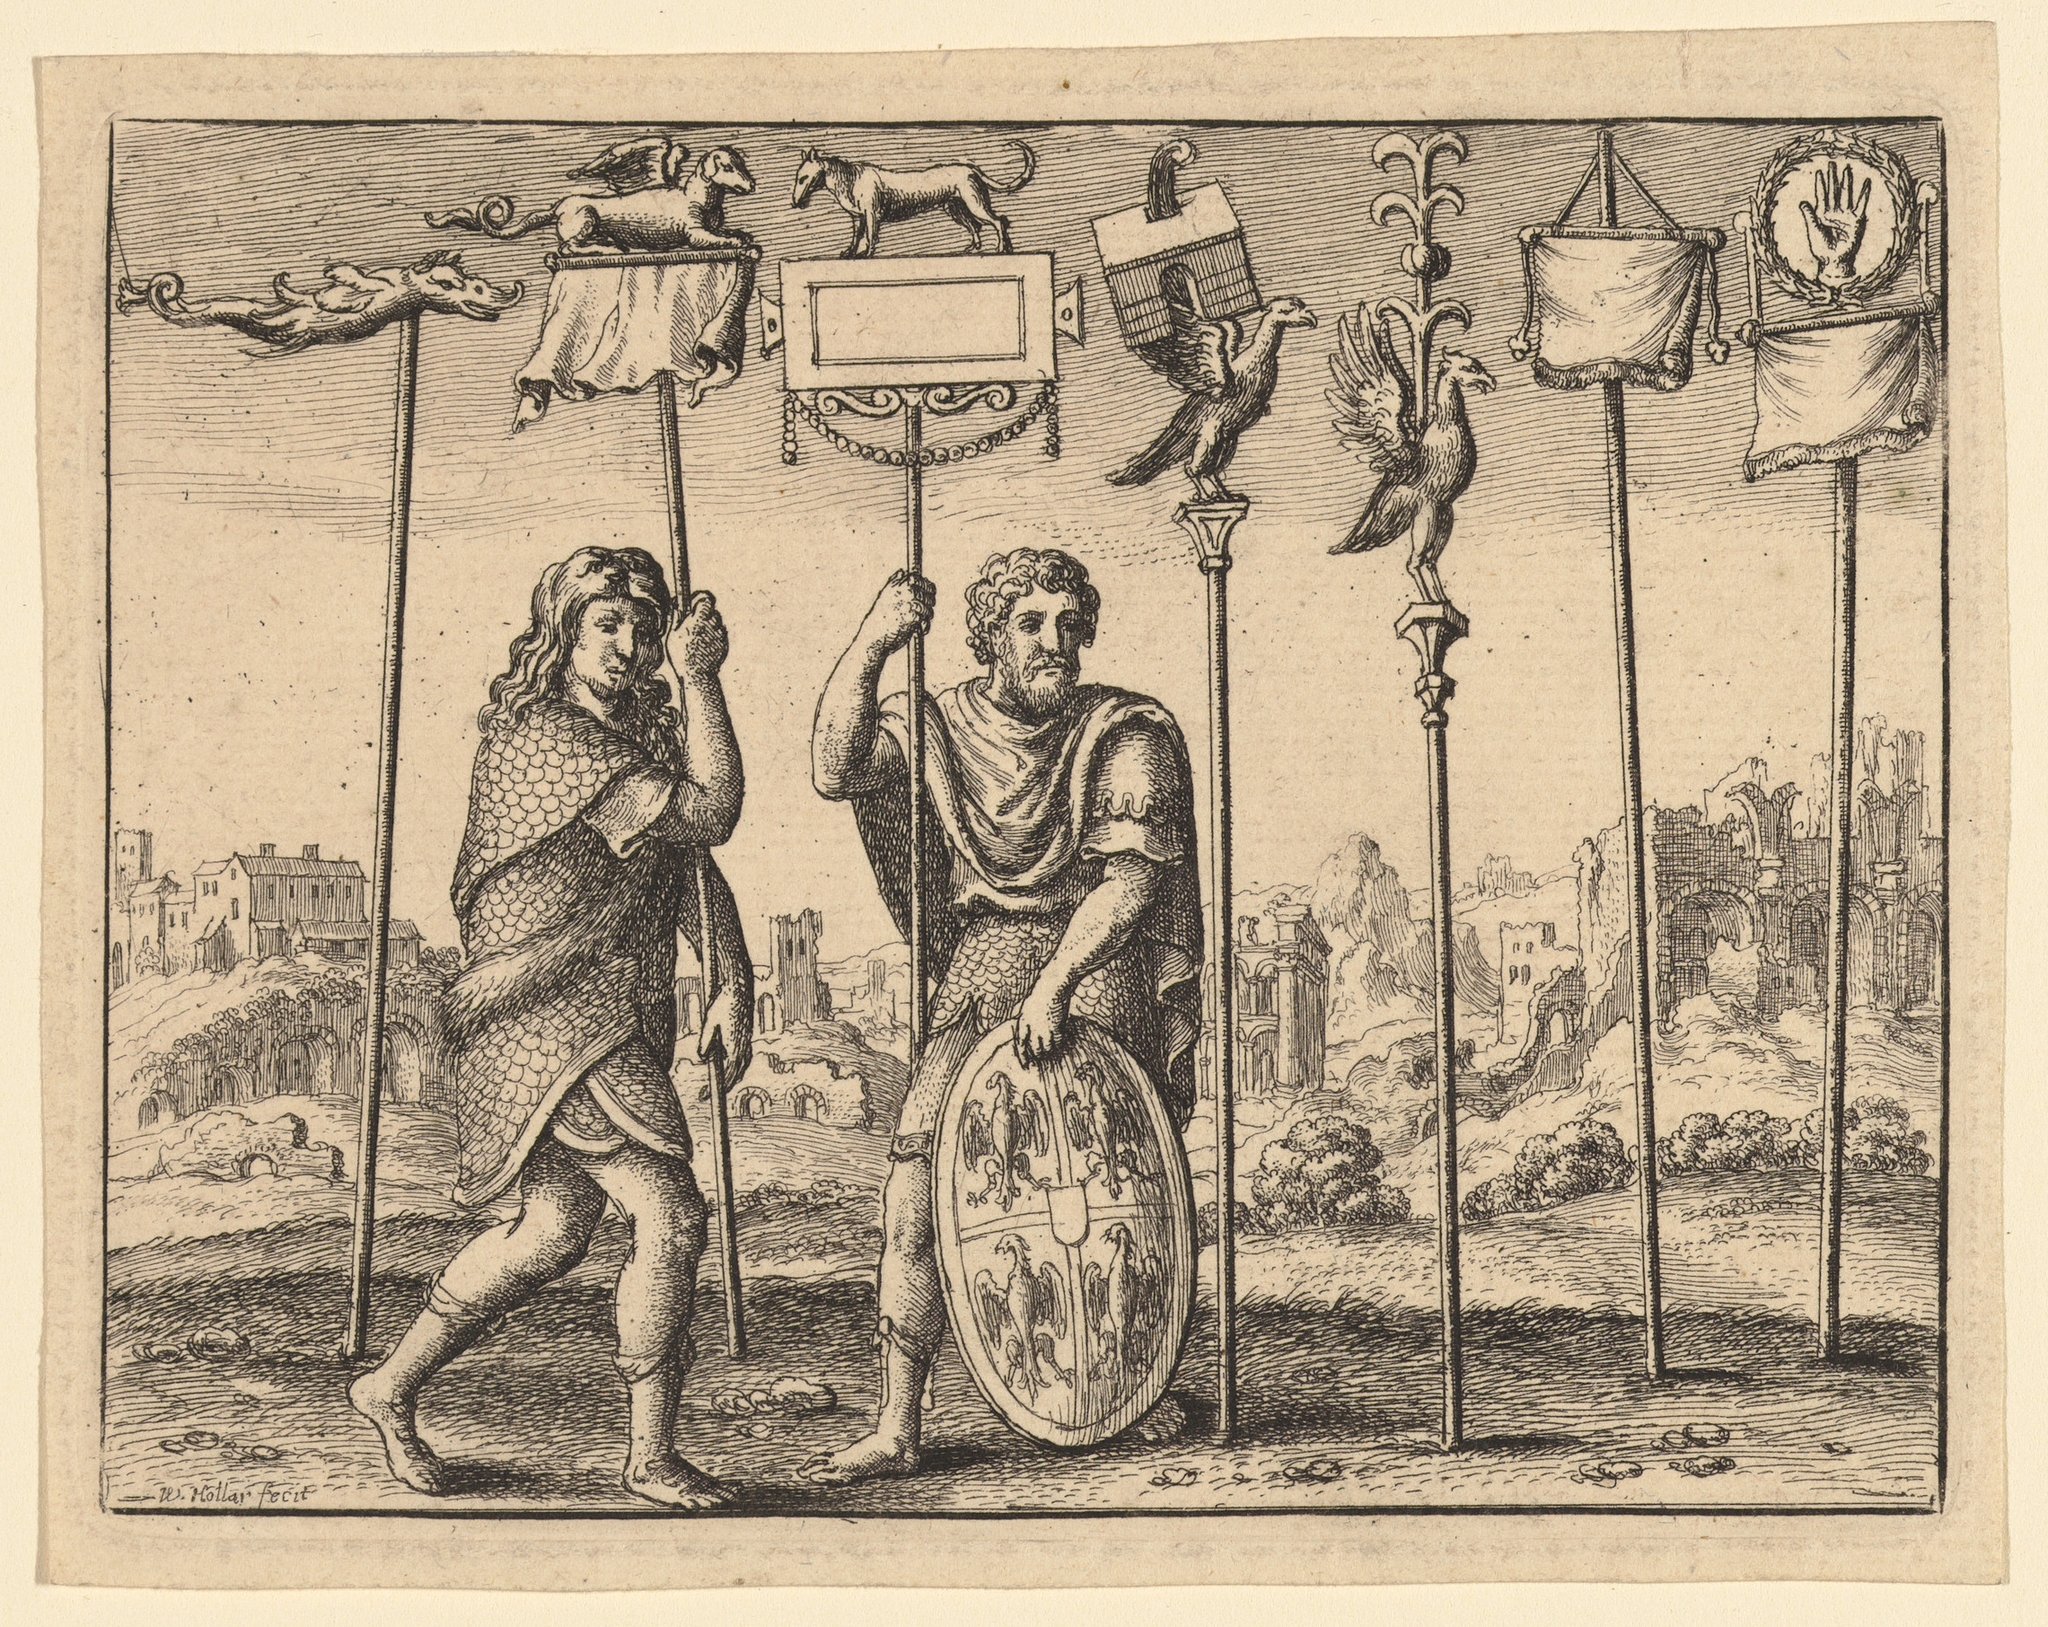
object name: print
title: Seven Roman Standards, from "De Studio militari..."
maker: wenceslaus hollar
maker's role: artist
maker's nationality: bohemian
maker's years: 1607-1677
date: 1654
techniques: etching